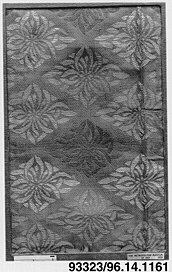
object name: piece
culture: japanese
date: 1701-1900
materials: silk